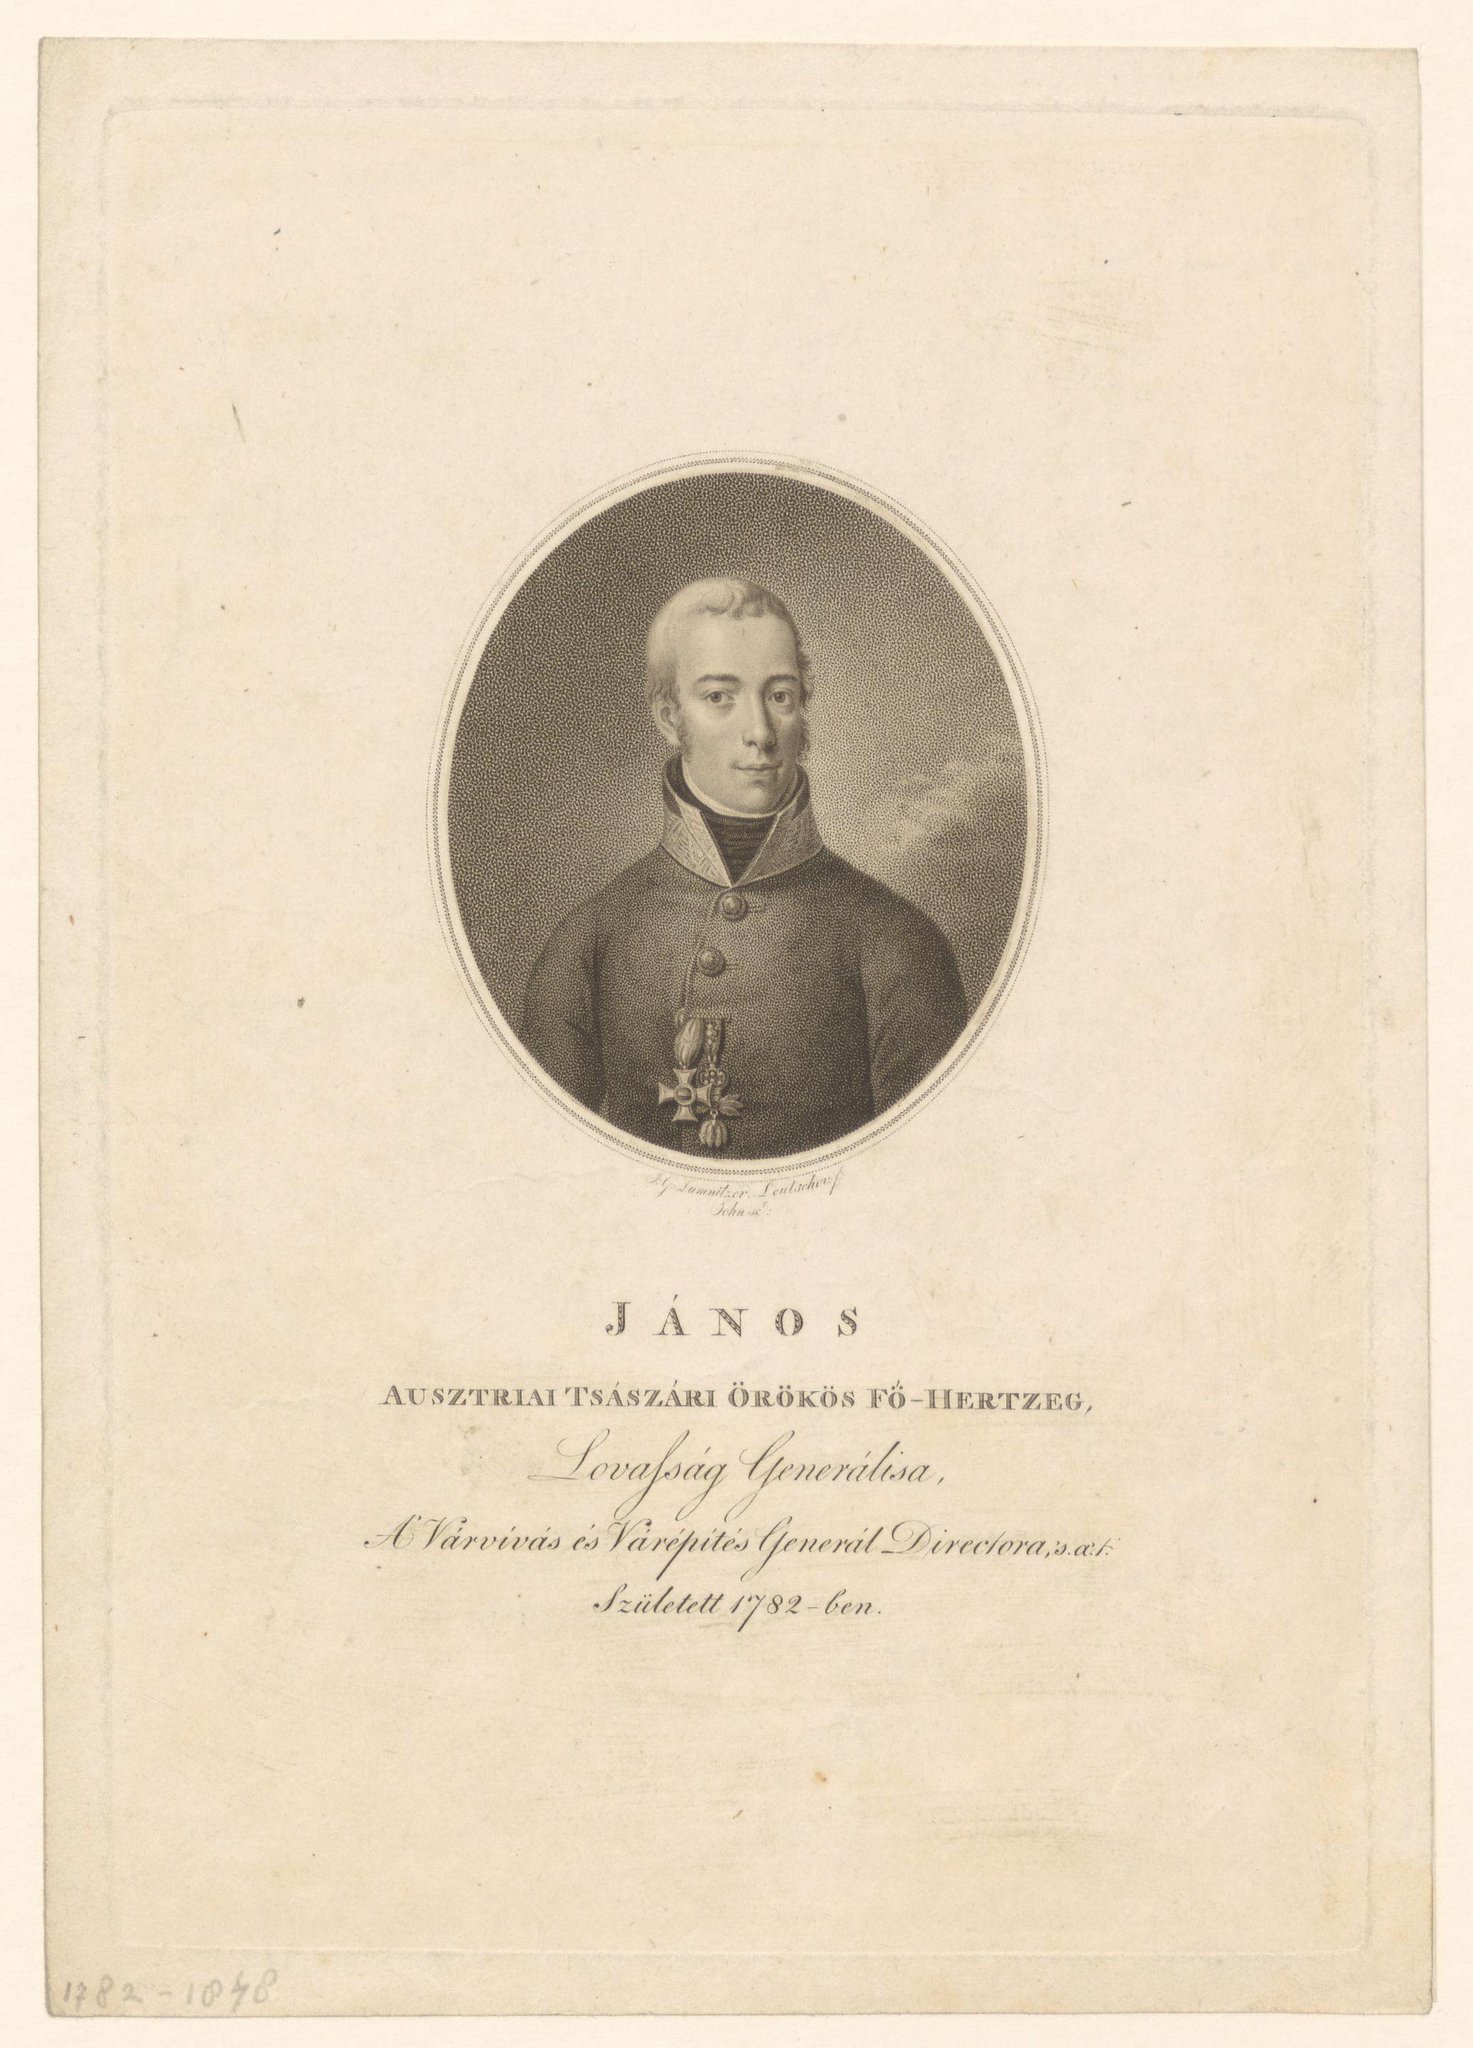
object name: print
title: Portret van Johan van Oostenrijk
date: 1808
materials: paper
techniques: stippling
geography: levoča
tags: commander-in-chief, general, marshal, historical persons, knighthood order of the golden fleece - insignia of a knighthood order, e.g.: badge, chain (with name of order)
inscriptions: collector's mark: Lugt 2228